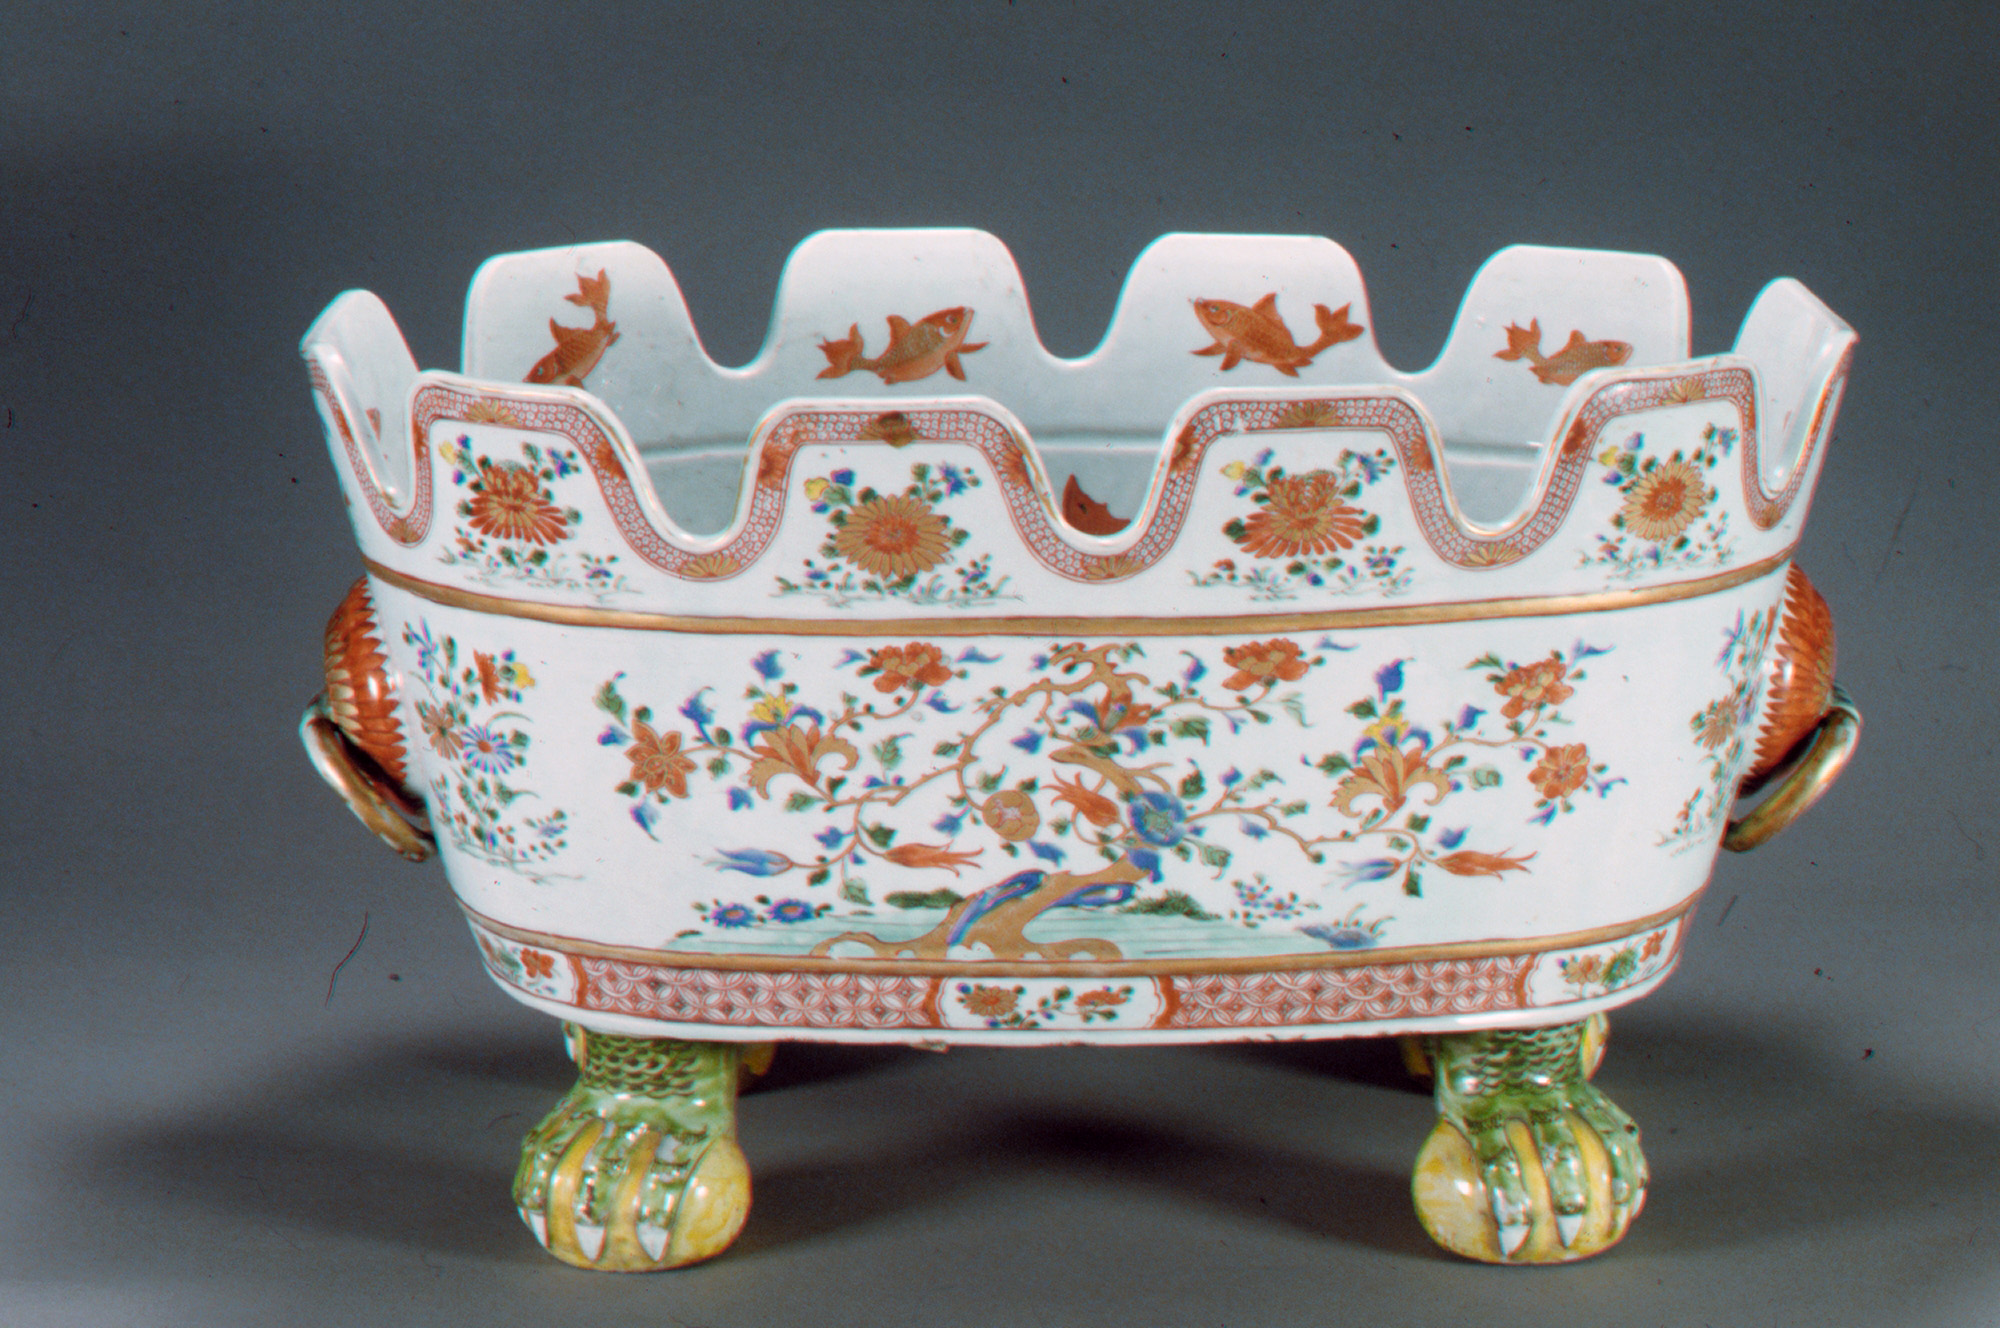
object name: monteith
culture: chinese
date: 1701-1733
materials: enamel, gilt, porcelain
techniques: overglaze, painting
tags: fish,flowers